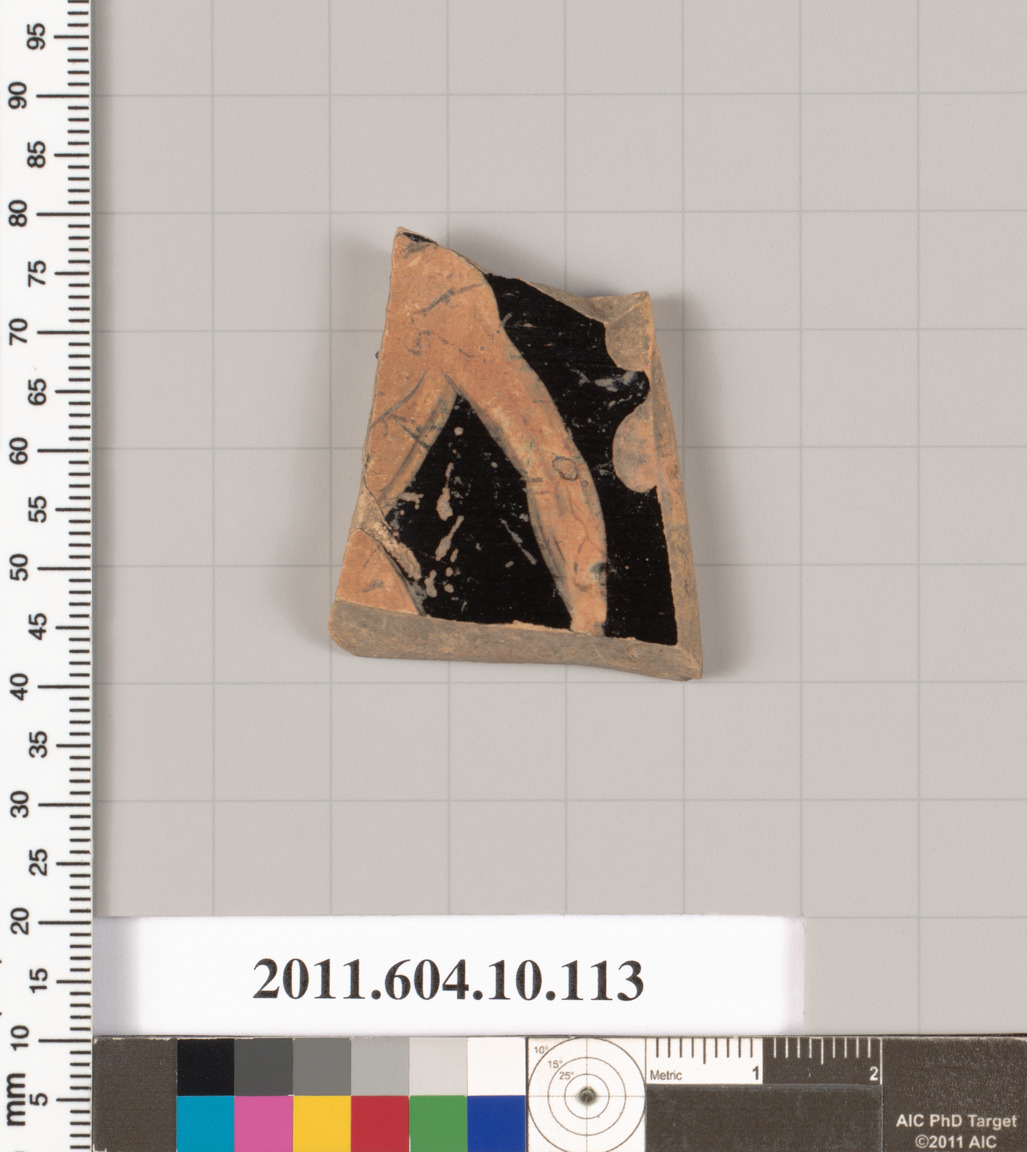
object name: undetermined open shape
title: Terracotta fragment of an open shape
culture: etruscan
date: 434-368 BCE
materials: terracotta